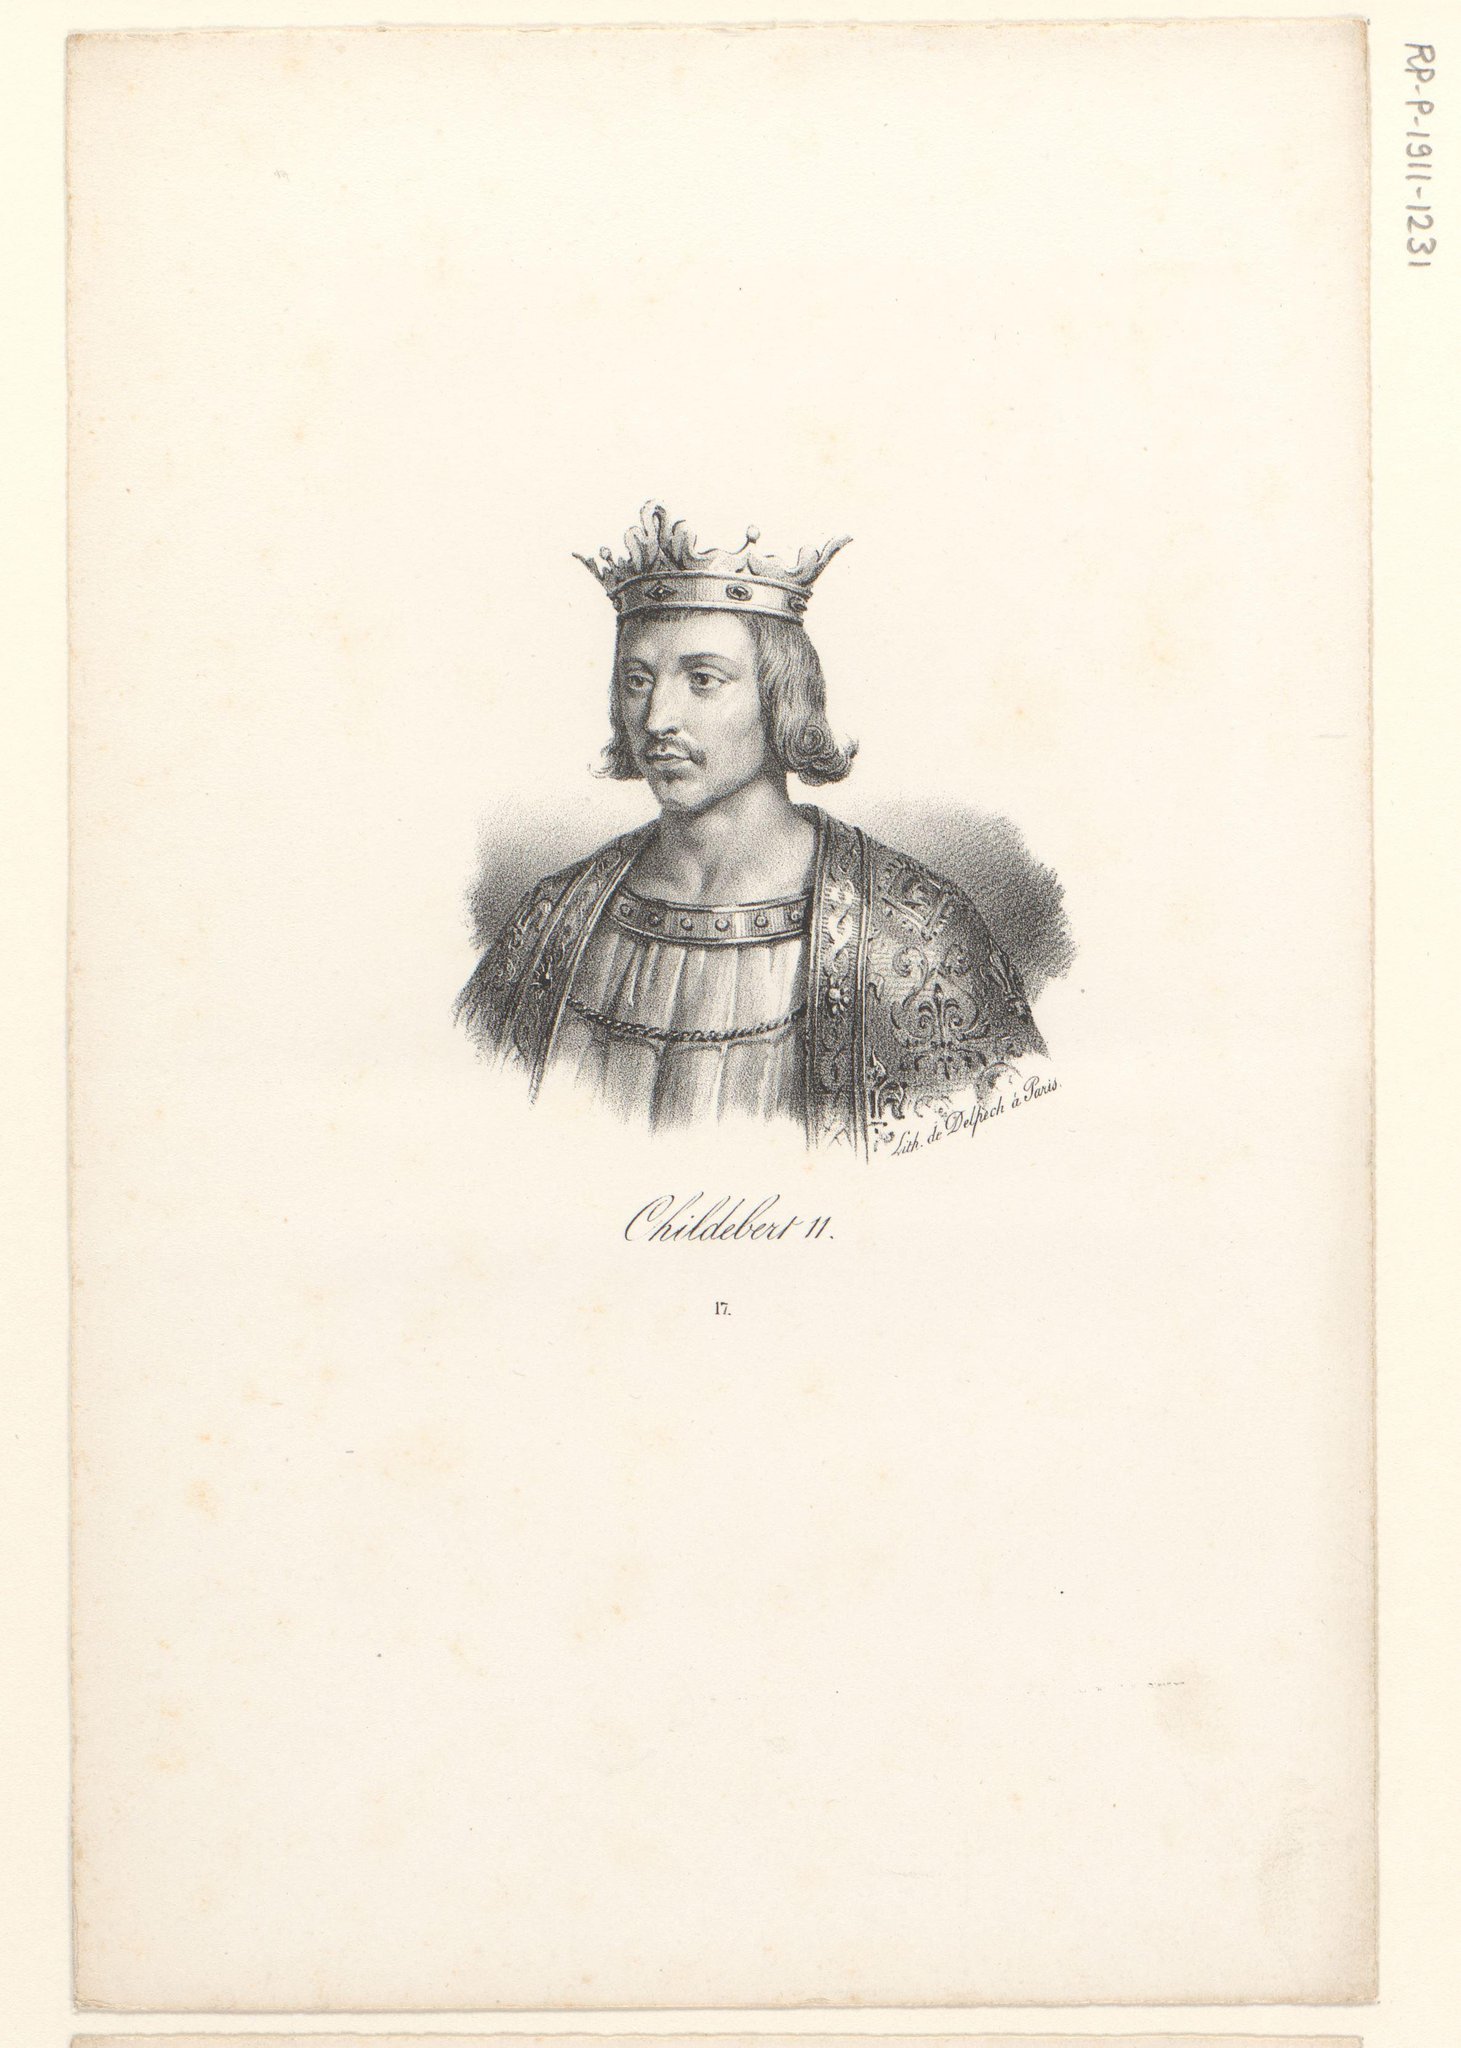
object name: print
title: Portret van koning Childebert II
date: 1818-1842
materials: paper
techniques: lithograph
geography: paris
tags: historical persons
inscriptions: collector's mark: Lugt 2228a